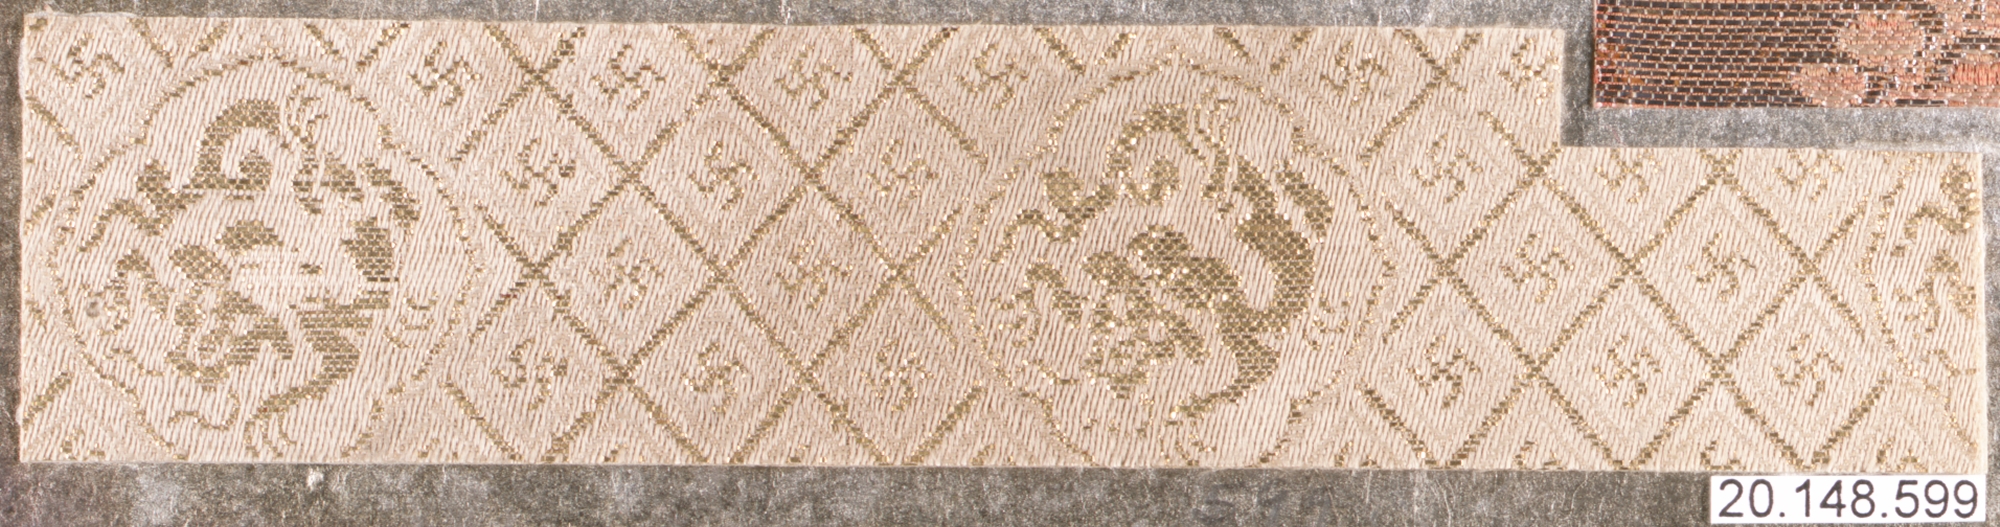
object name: piece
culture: japanese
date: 1701-1800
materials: silk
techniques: compound weave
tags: dragons